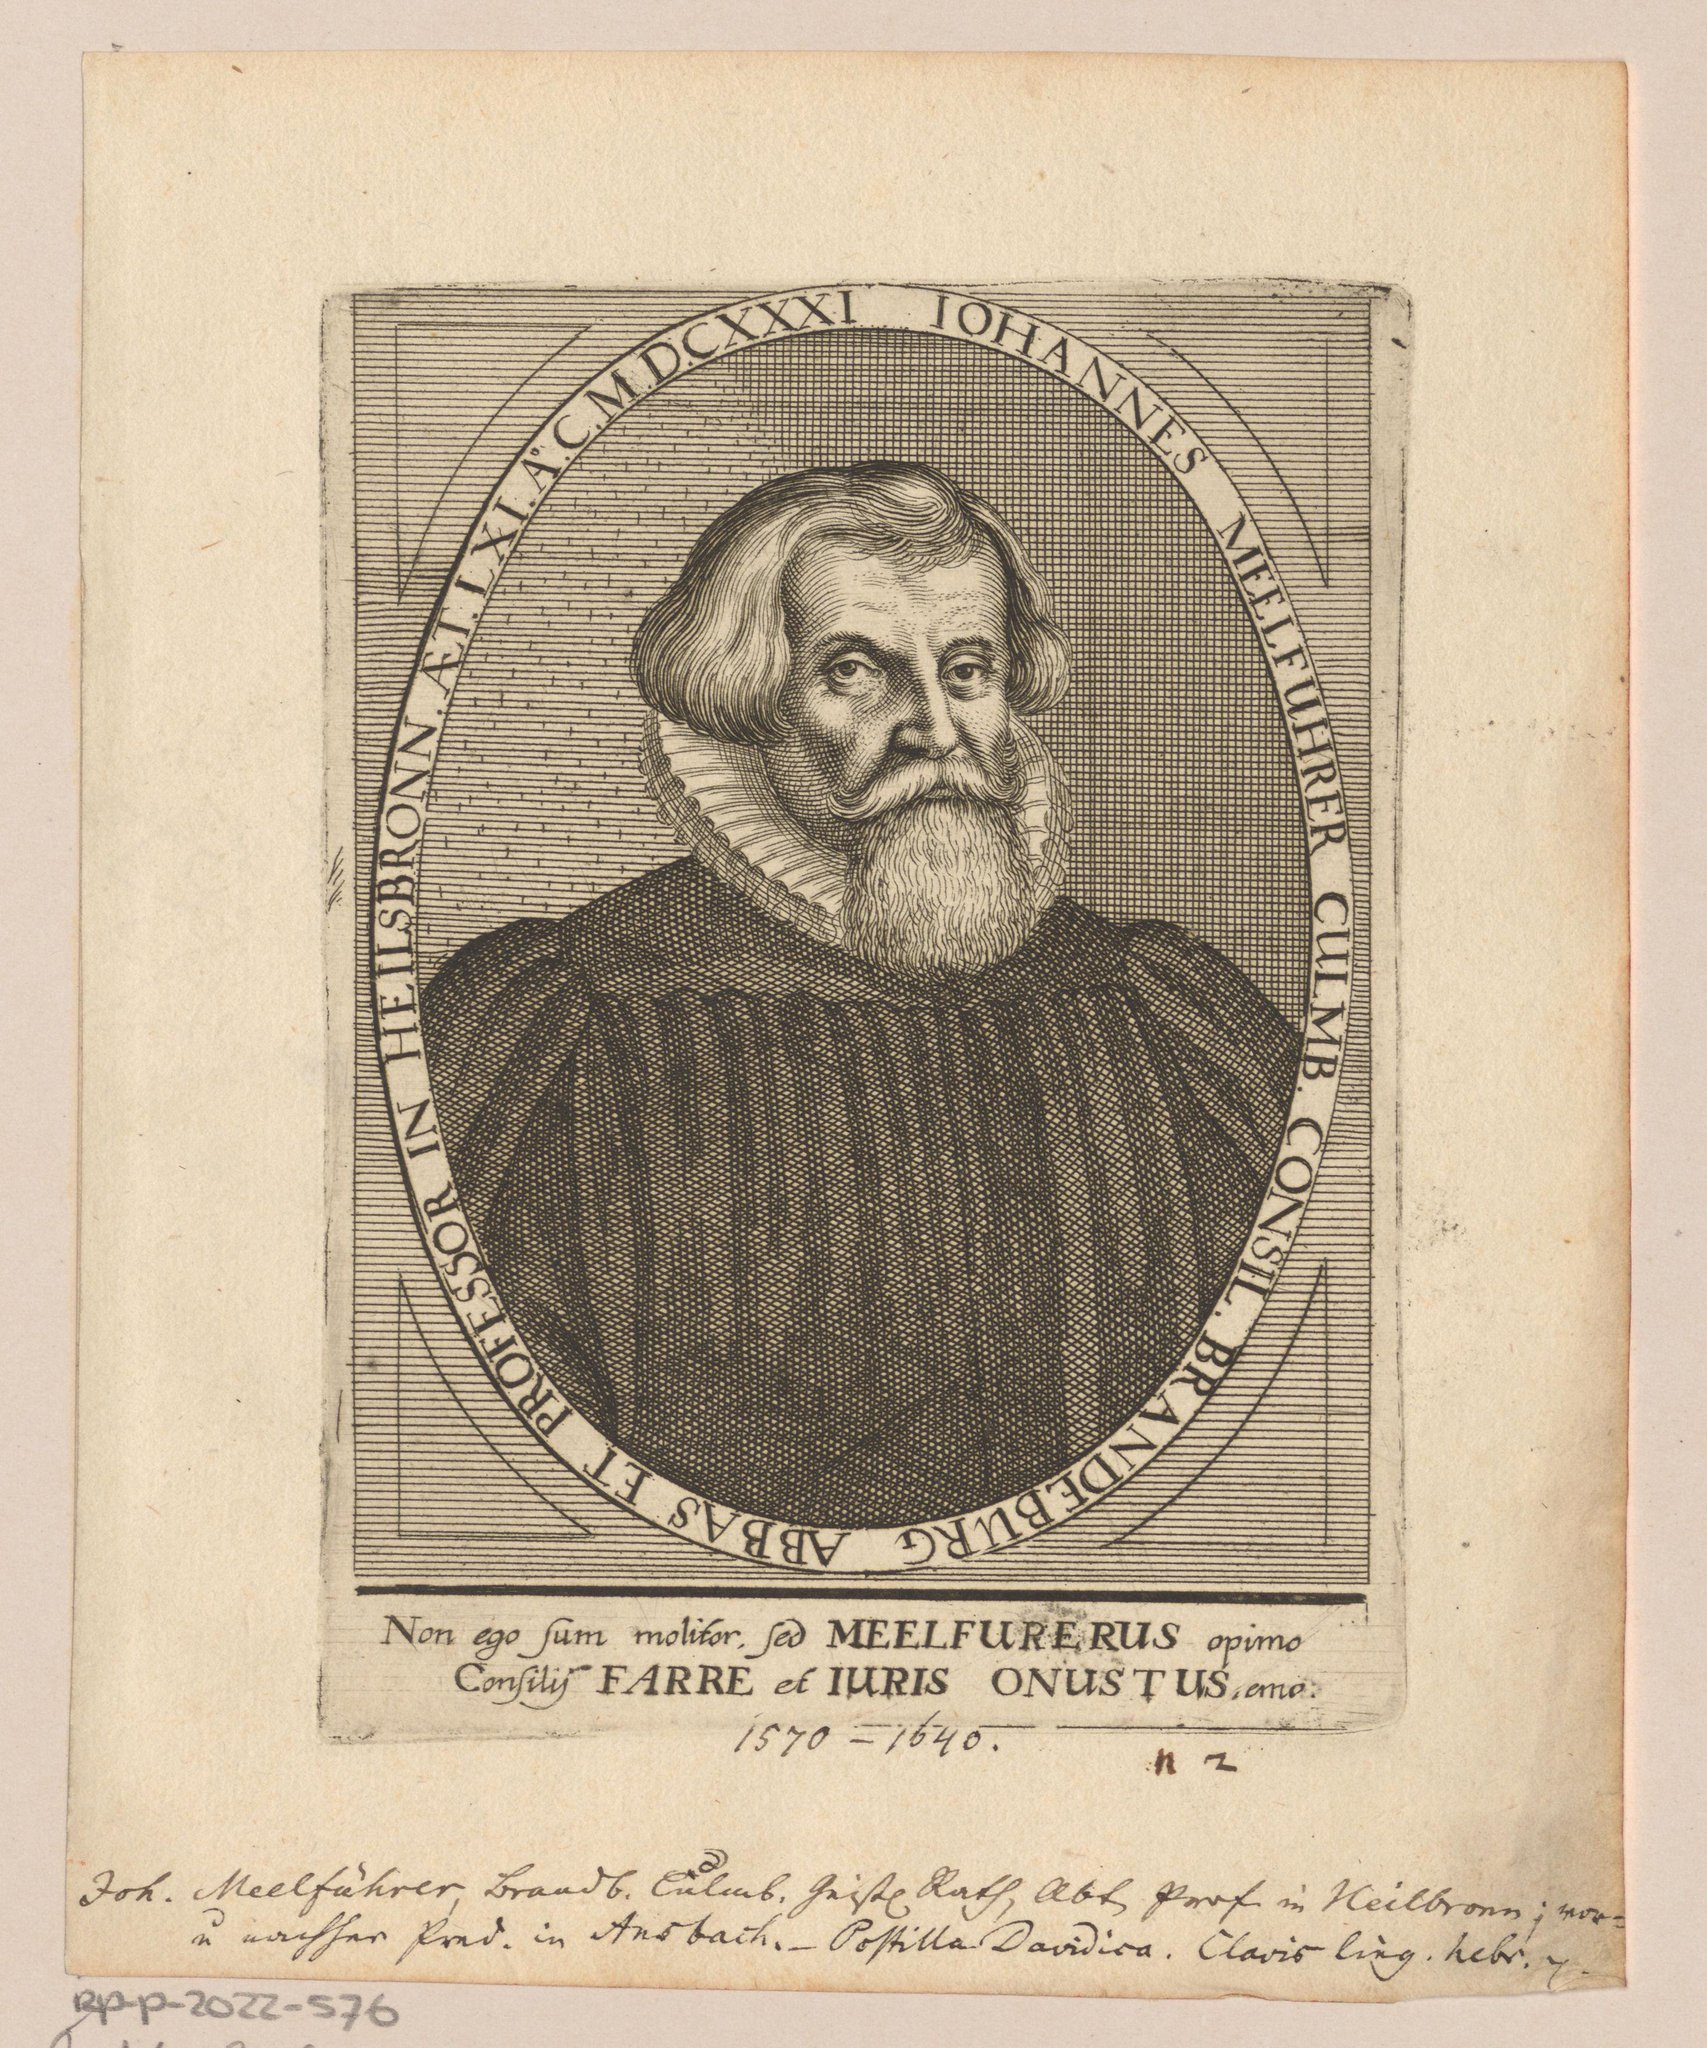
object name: print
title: Portret van Johann Christoph Meelführer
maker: Anonymous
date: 1650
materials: paper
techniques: engraving, etching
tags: johann christoph meelführer, historical persons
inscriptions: inscription: ‘1570 - 1640. /Joh. Meelführer, [...] / [...] hebr.’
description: Met tweeregelig onderschrift in het Latijn.